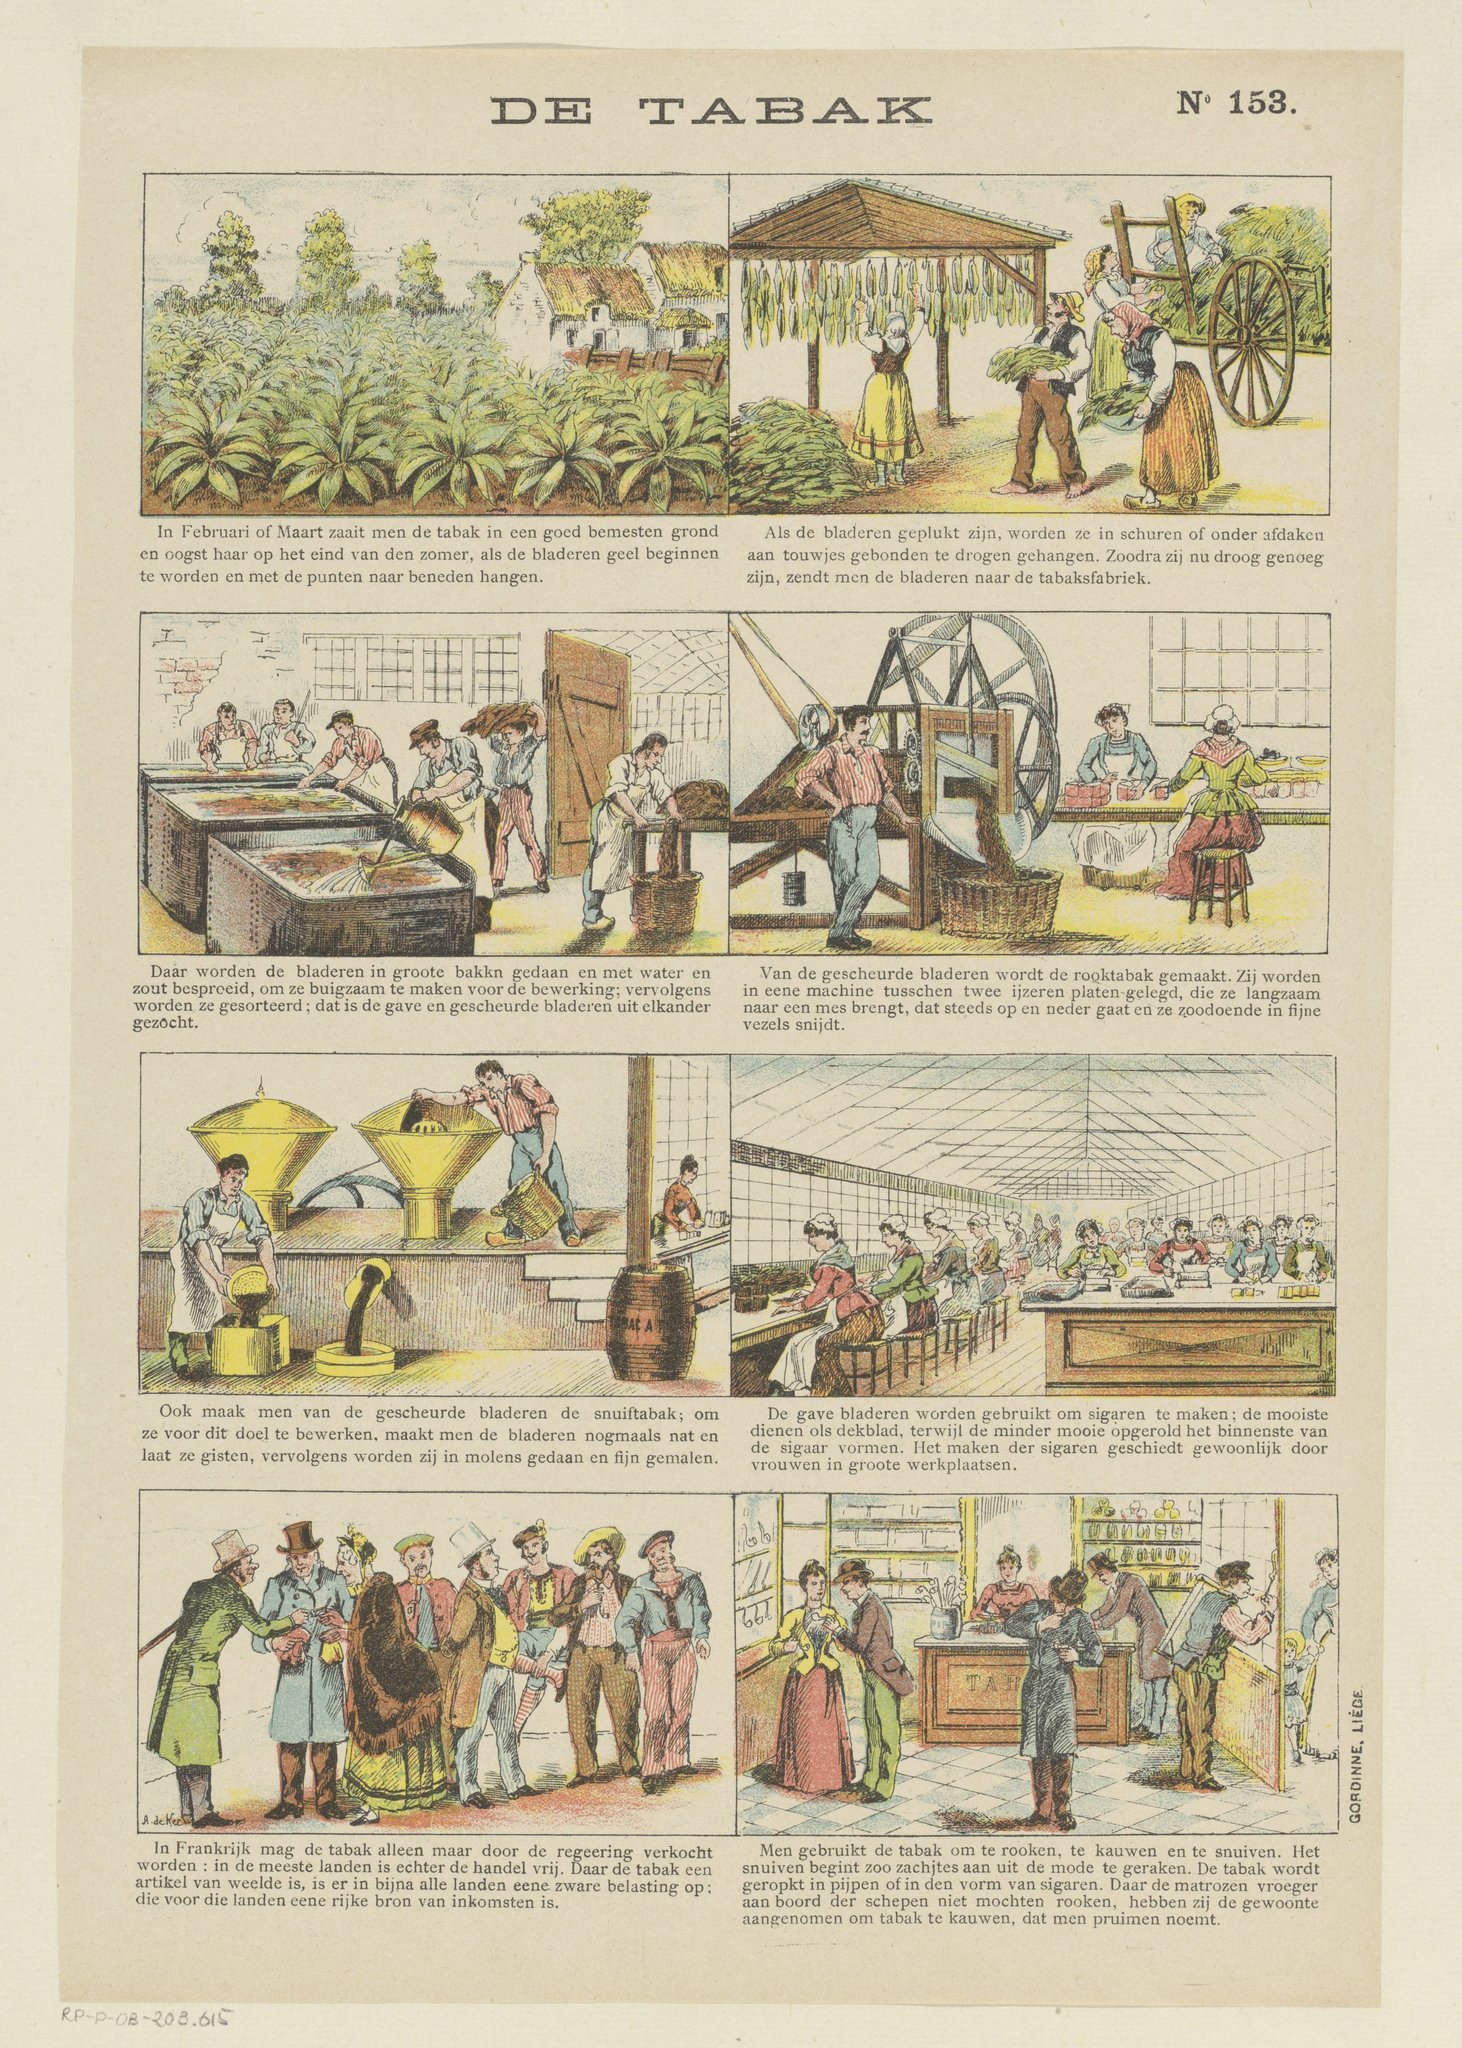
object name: popular print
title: De tabak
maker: a. de ker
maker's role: print maker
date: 1894-1959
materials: paper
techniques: lithograph, letterpress printing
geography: liège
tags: tobacco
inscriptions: collector's mark: Lugt 2760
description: Blad met 8 voorstellingen over het productieproces van tabak. Onder elke afbeelding een onderschrift. Genummerd rechtsboven: No 153.